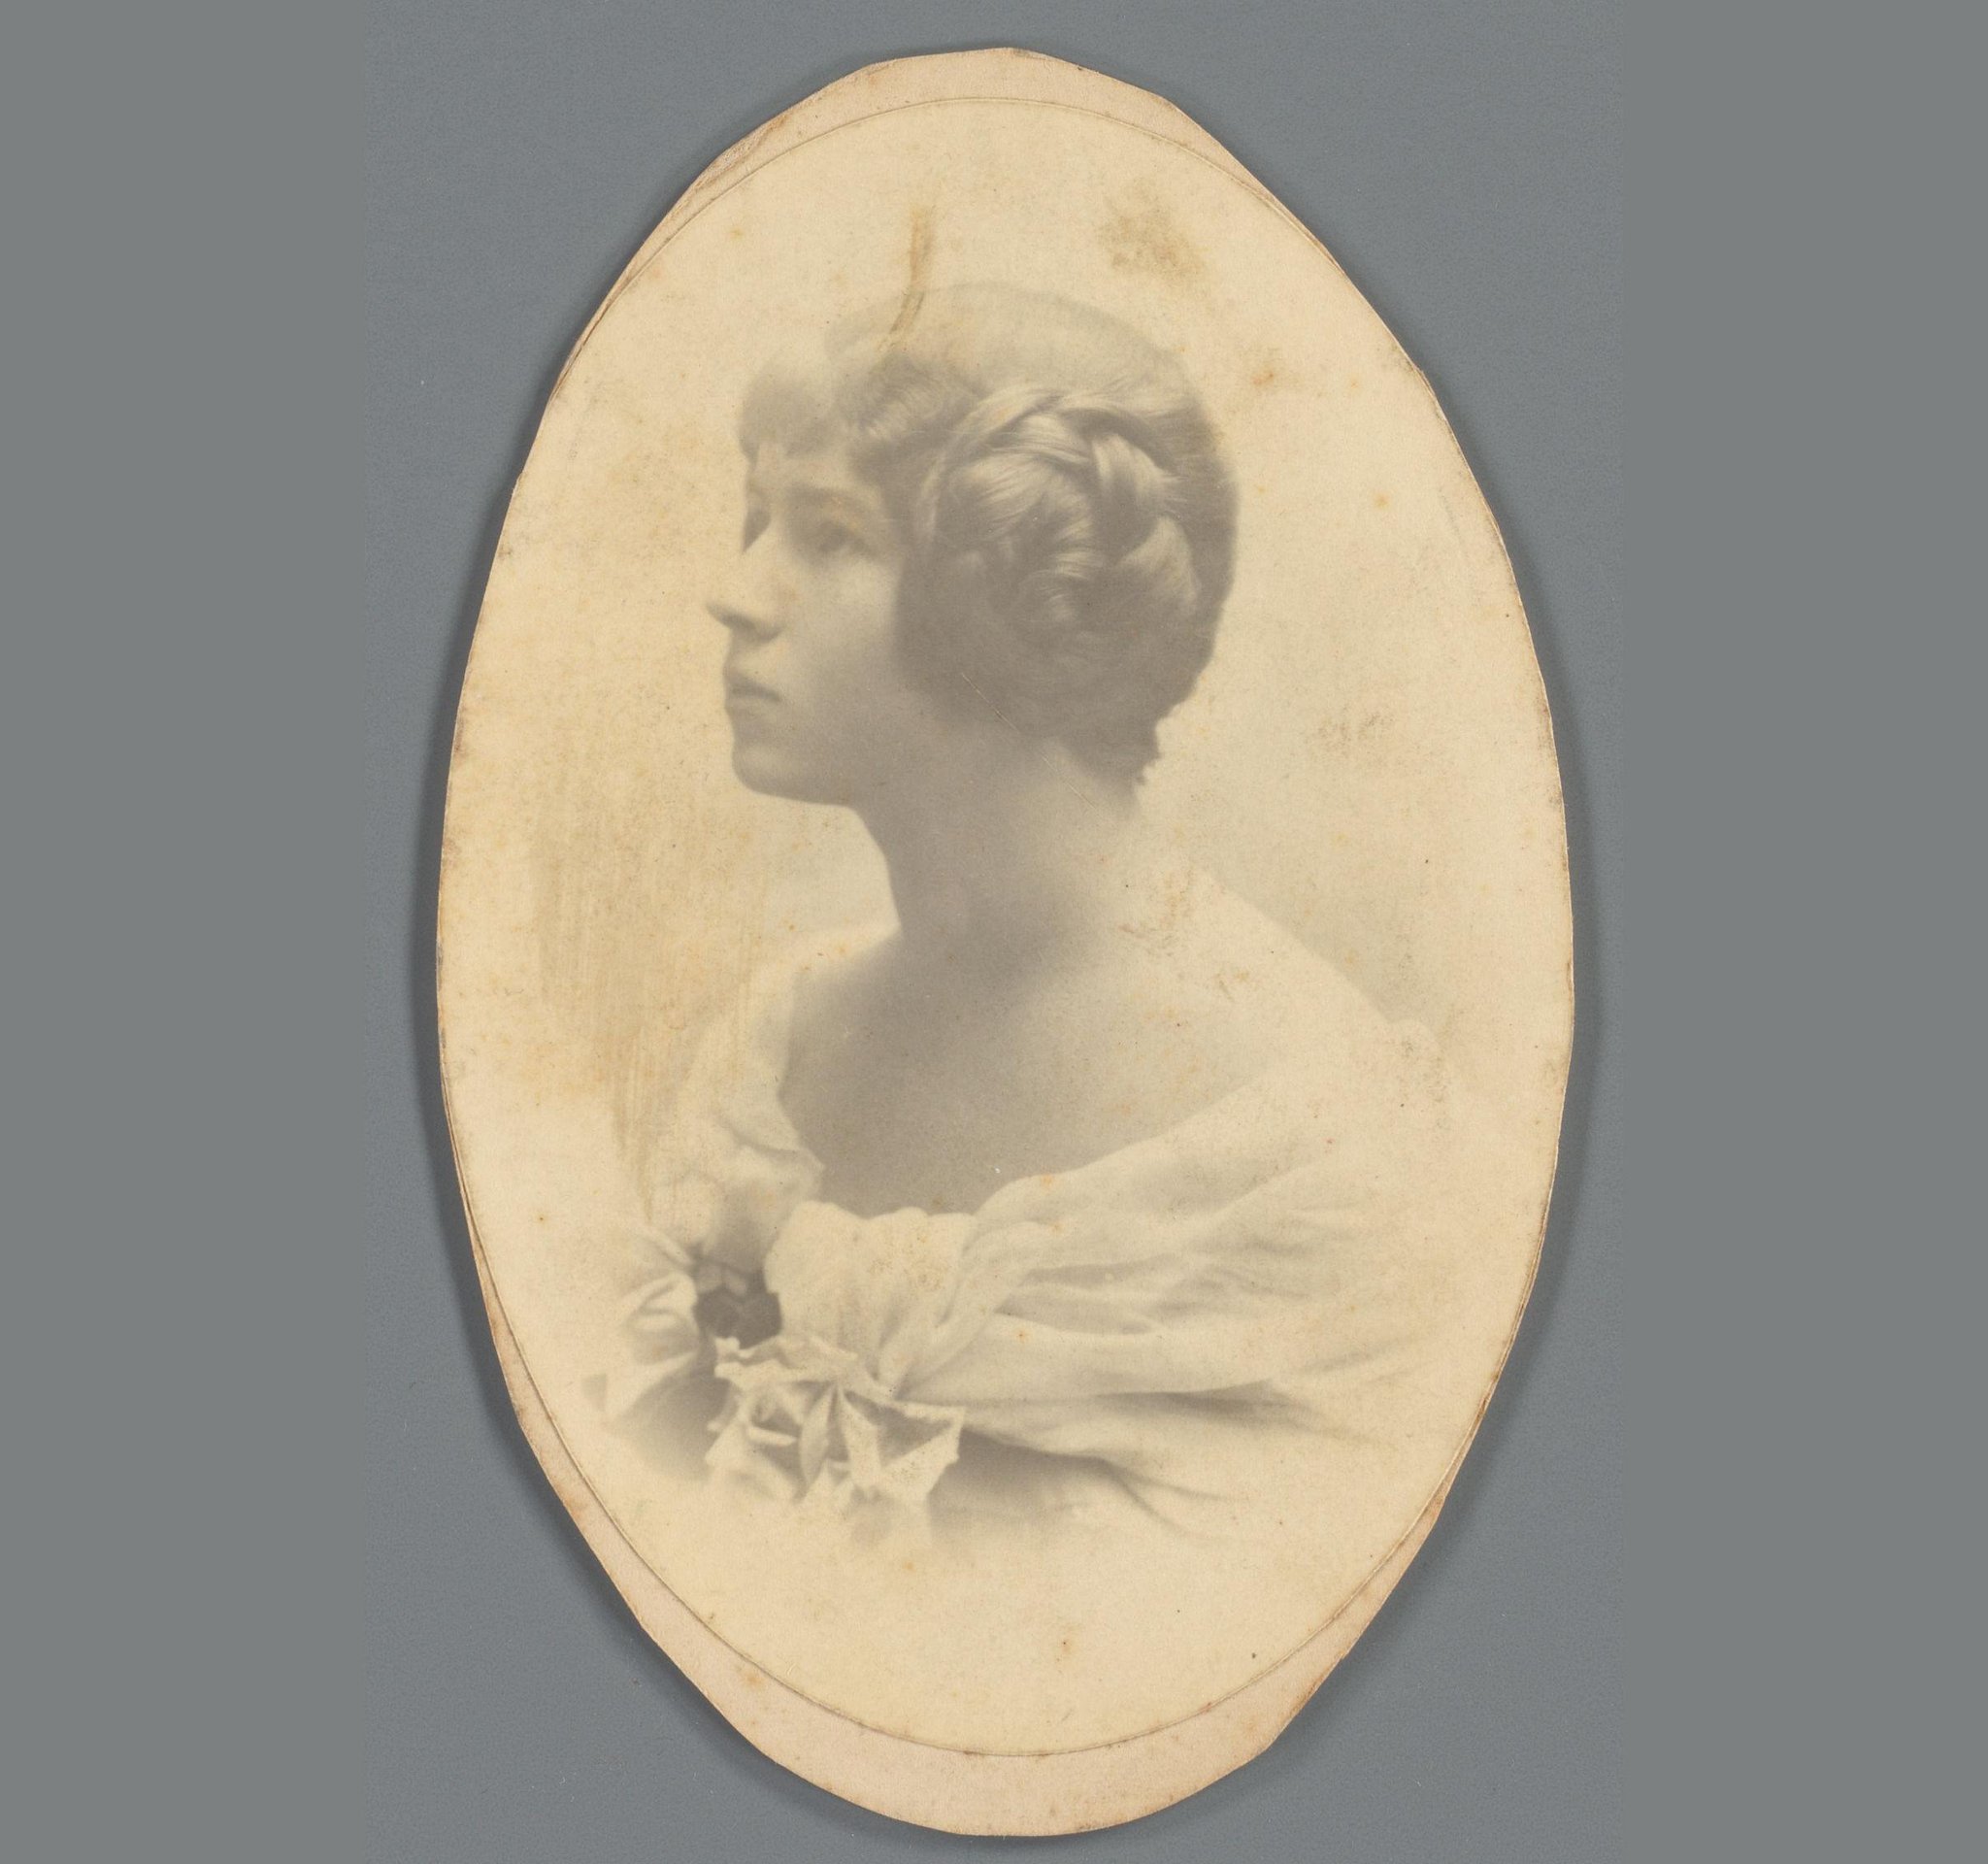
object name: photograph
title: Portret van een vrouw, aangeduid als Lil Mohr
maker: Anonymous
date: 1910-1930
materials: paper, cardboard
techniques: gelatin silver print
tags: historical persons